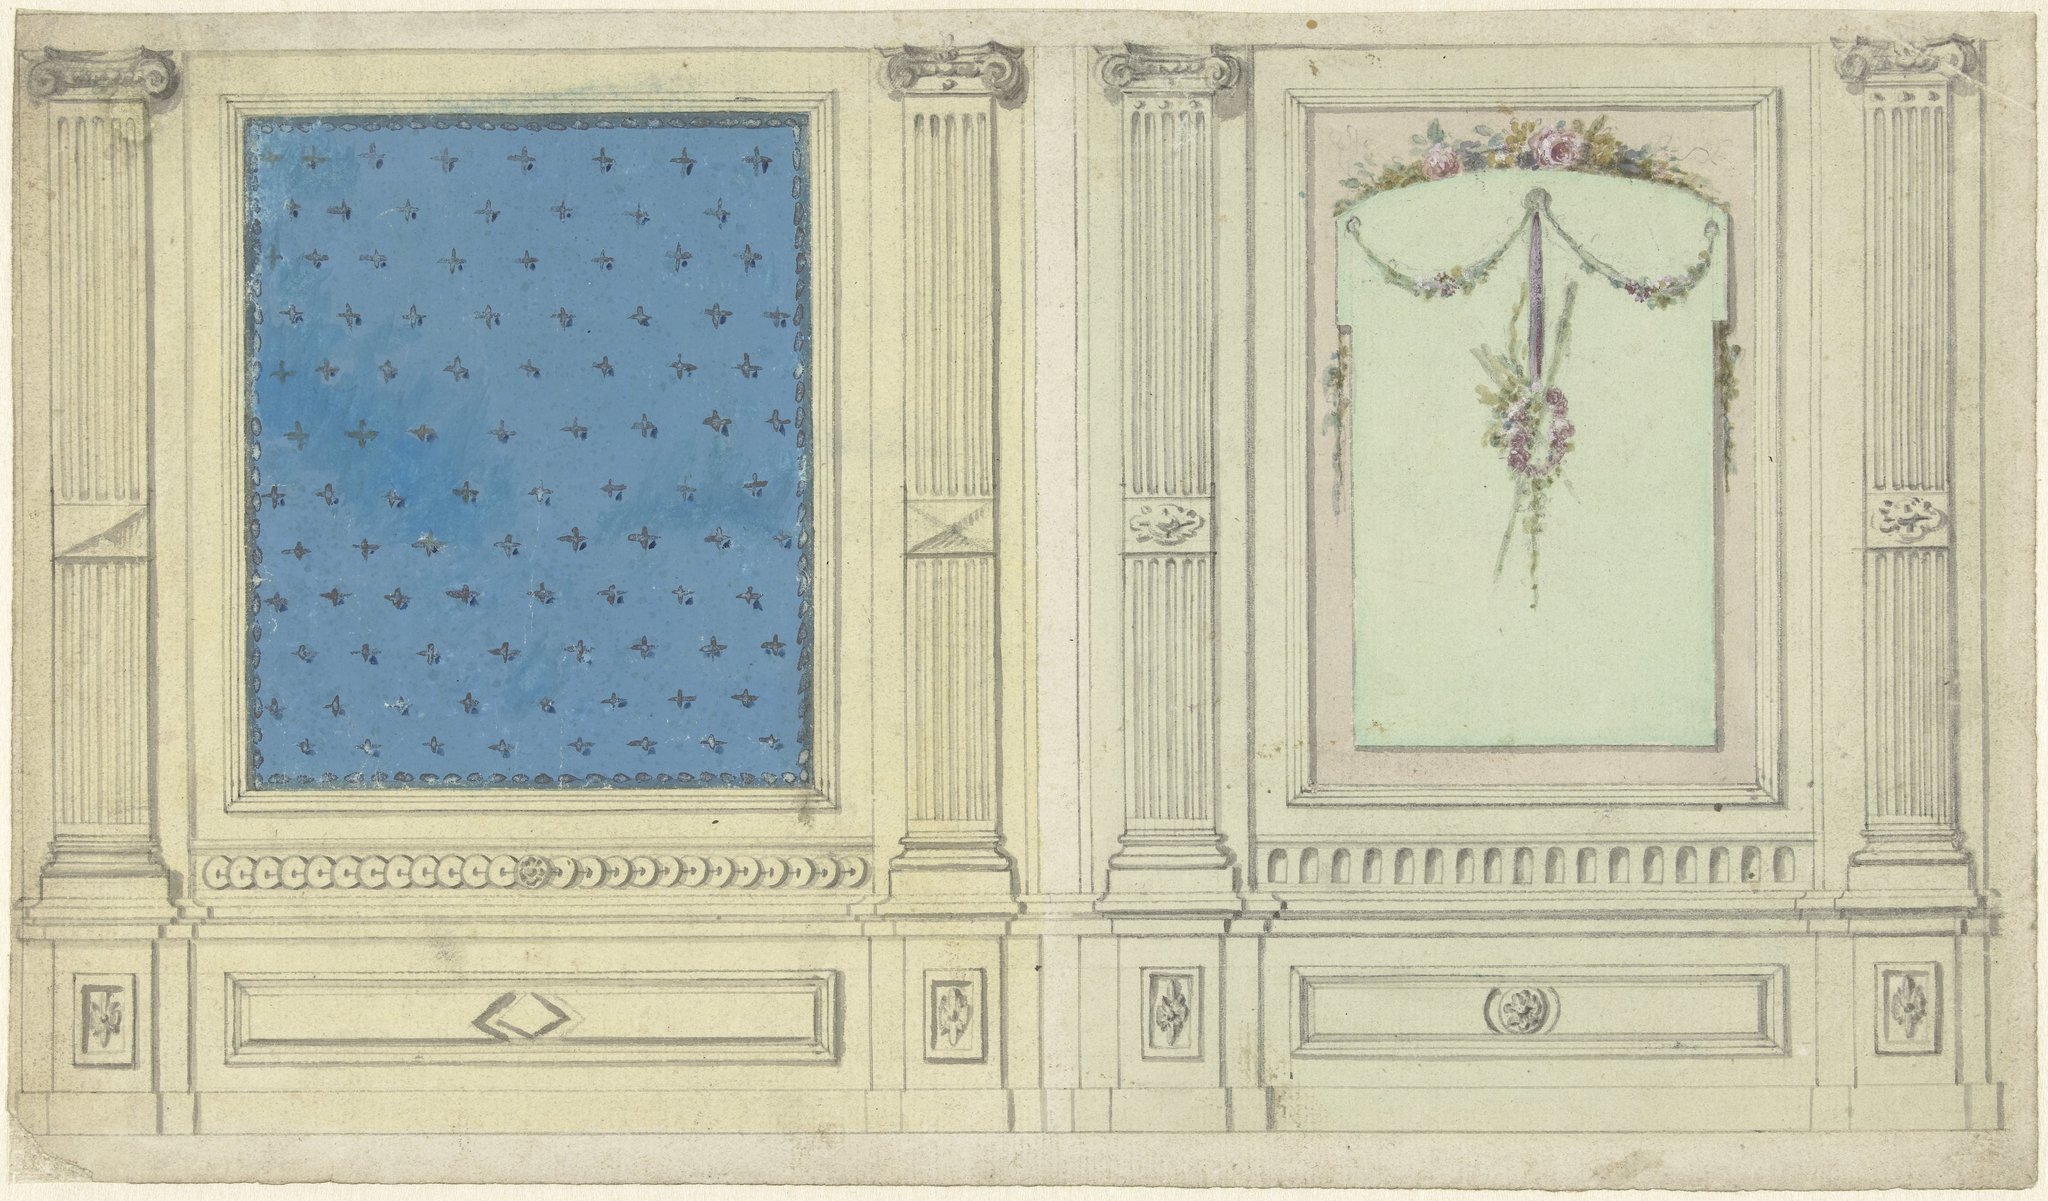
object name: drawing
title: Ontwerp voor kamerversiering met een paneel met sterren en een paneel met bloemenguirlandes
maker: abraham meertens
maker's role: draughtsman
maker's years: 1757-1823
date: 1767-1823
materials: paint, ink, paper, pencil, watercolor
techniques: brush, pen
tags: wall-covering